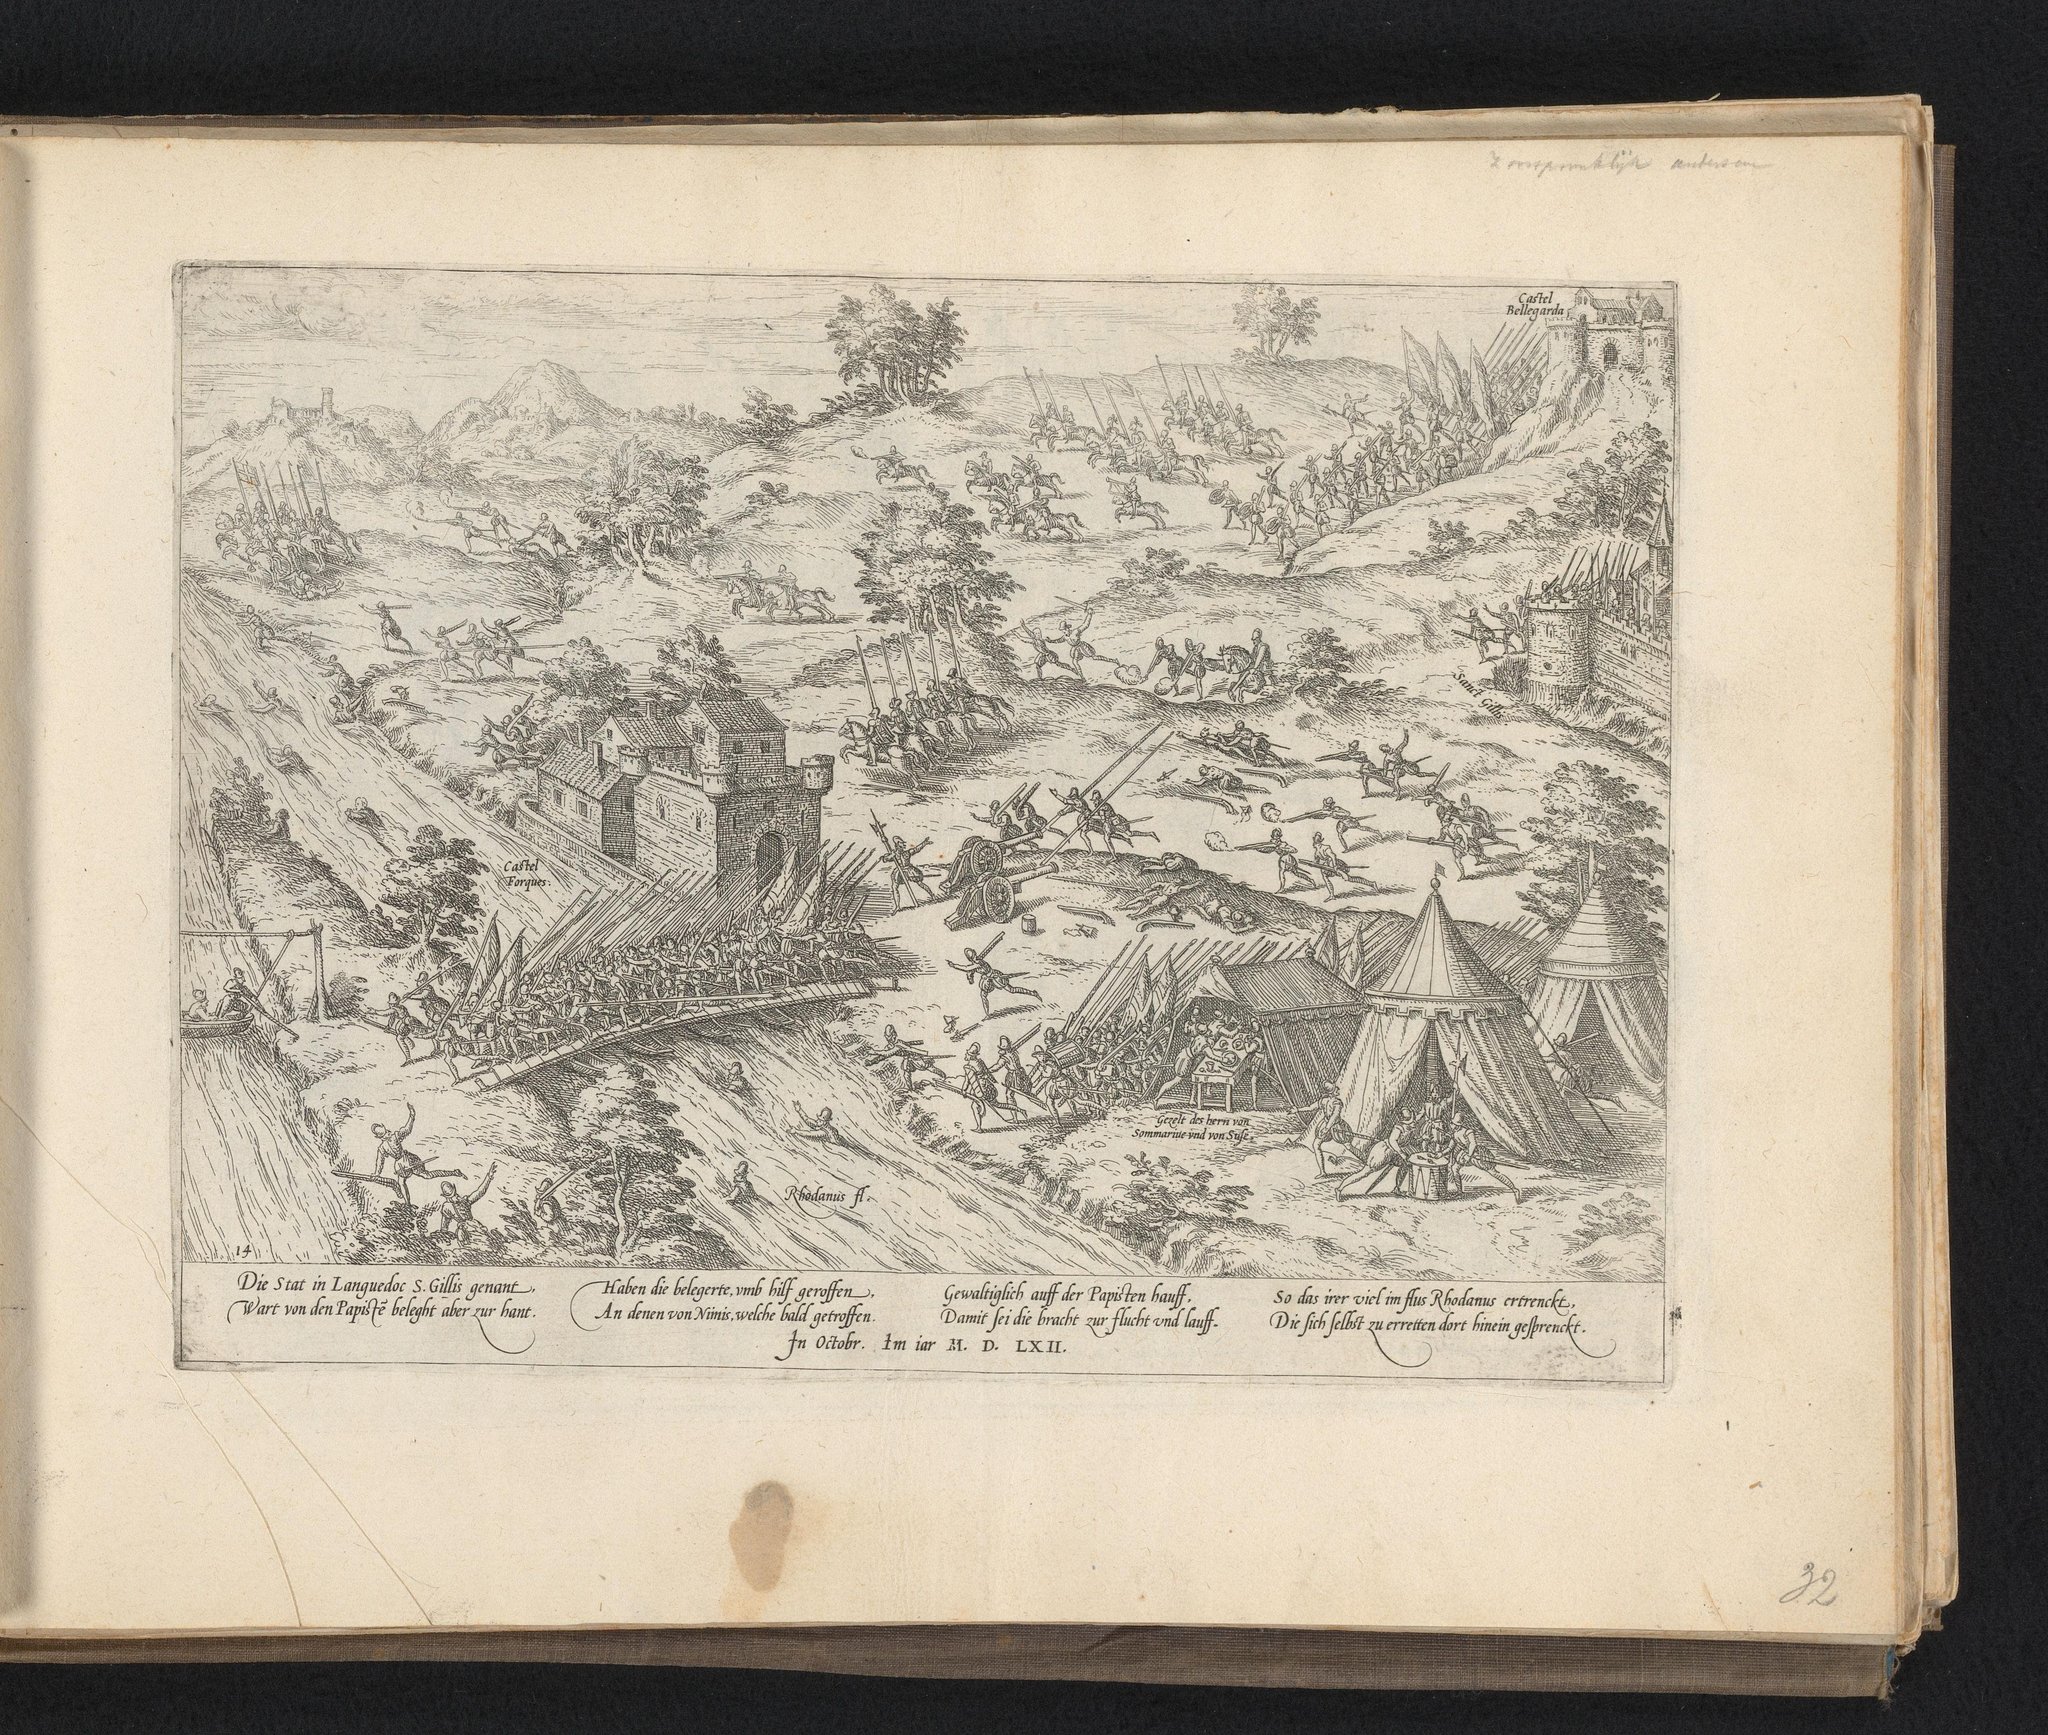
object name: album leaf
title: Saint-Gilles ontzet door de protestanten uit Nîmes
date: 1562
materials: paper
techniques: etching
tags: raising the siege with outside assistance, relief, militant proselytizing: religious war, crusade, etc., the roman catholic church vs. protestantism; (reformation and counter reformation)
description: Prent gebruikt in: Aitsinger, Michael. De Leone Belgico (...). Keulen: s.n., 1588.